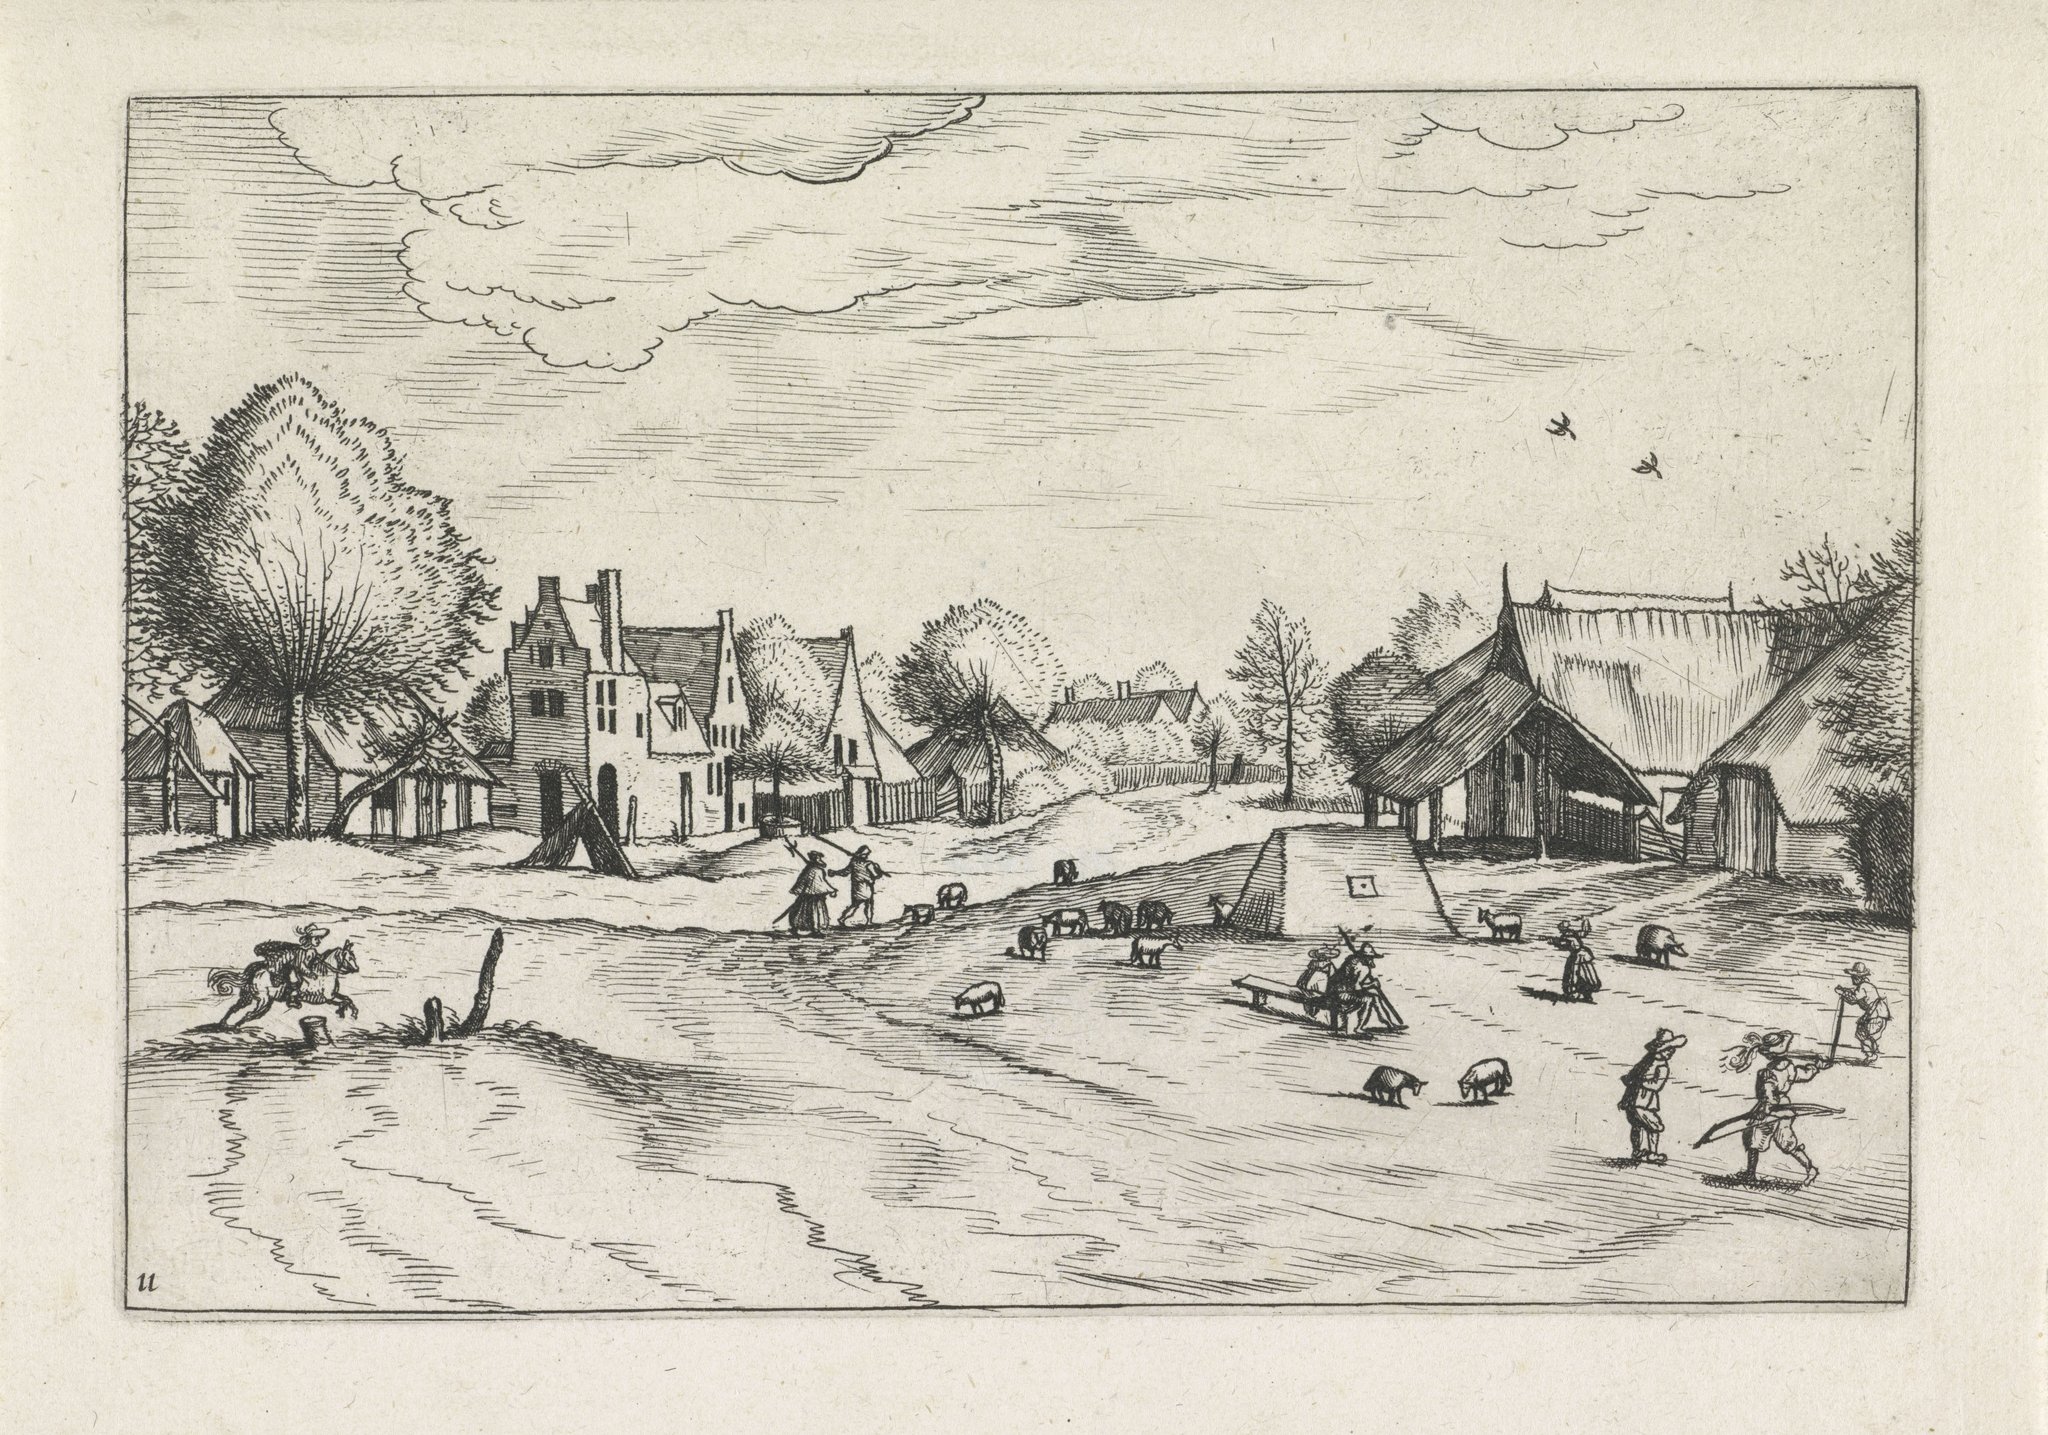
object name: print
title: Dorp met schapen en zittende herder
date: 1559-1561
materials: paper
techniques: etching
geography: antwerp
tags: sheep, public road in village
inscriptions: collector's mark: Lugt 2228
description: Gezicht op een dorp met op de voorgrond een kudde schapen en een herder op een bankje.